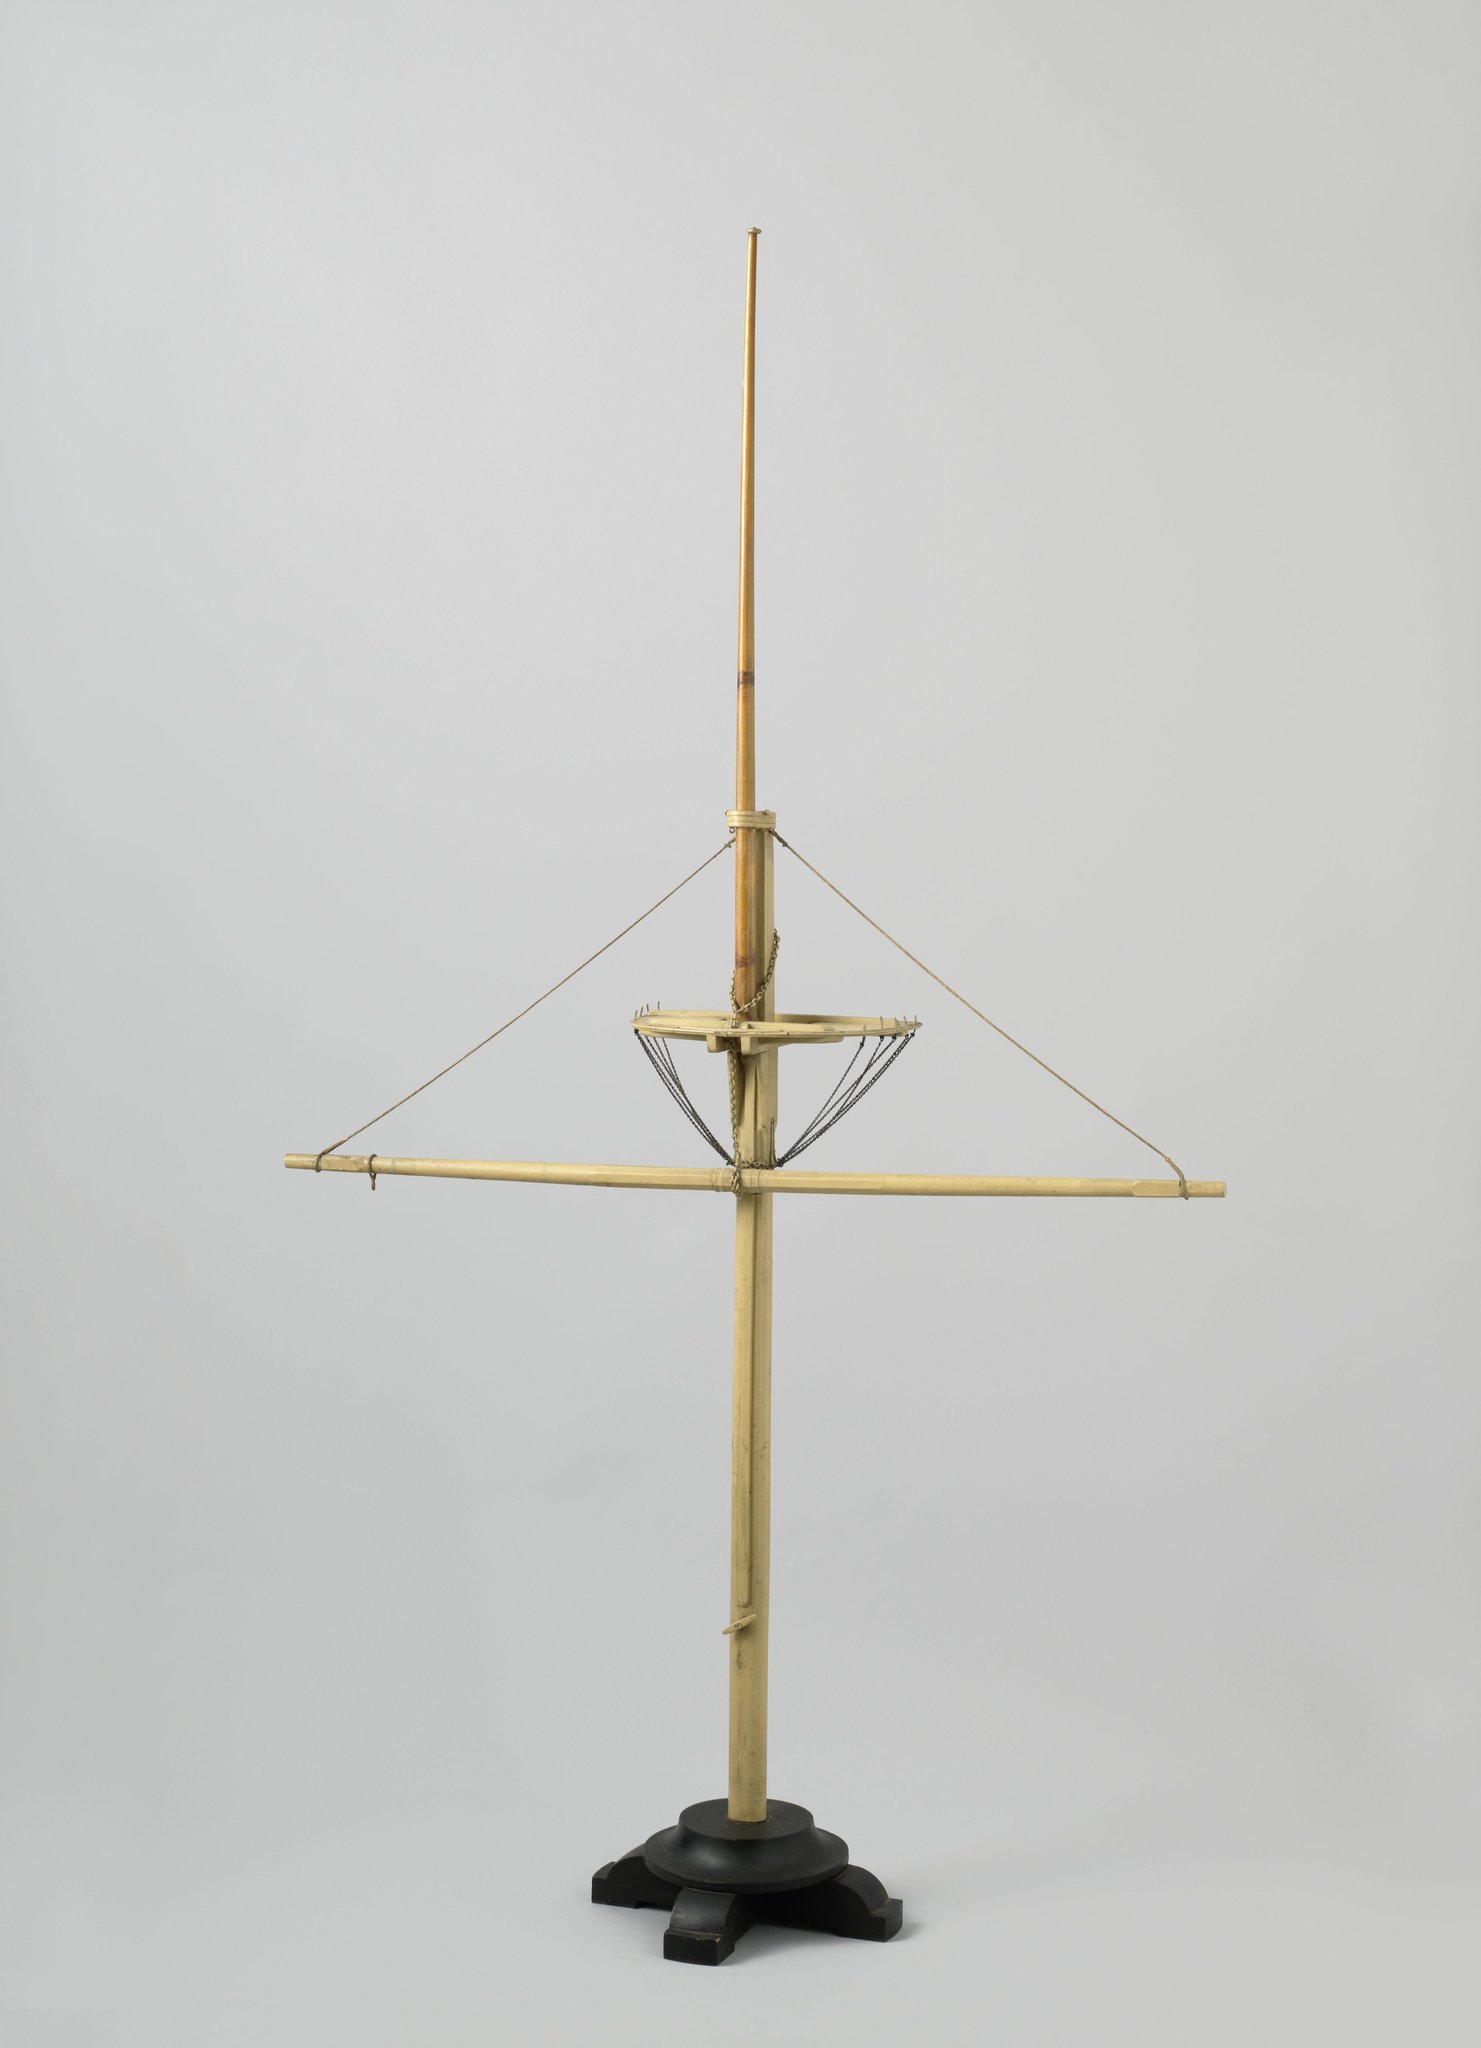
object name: scale model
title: Model of a Mast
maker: Anonymous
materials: brass, fiber, wood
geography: netherlands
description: Model van een ondermast met mars, ra en vlaggestok. De ra is met een borgketting aan het ezelshoofd bevestigd.